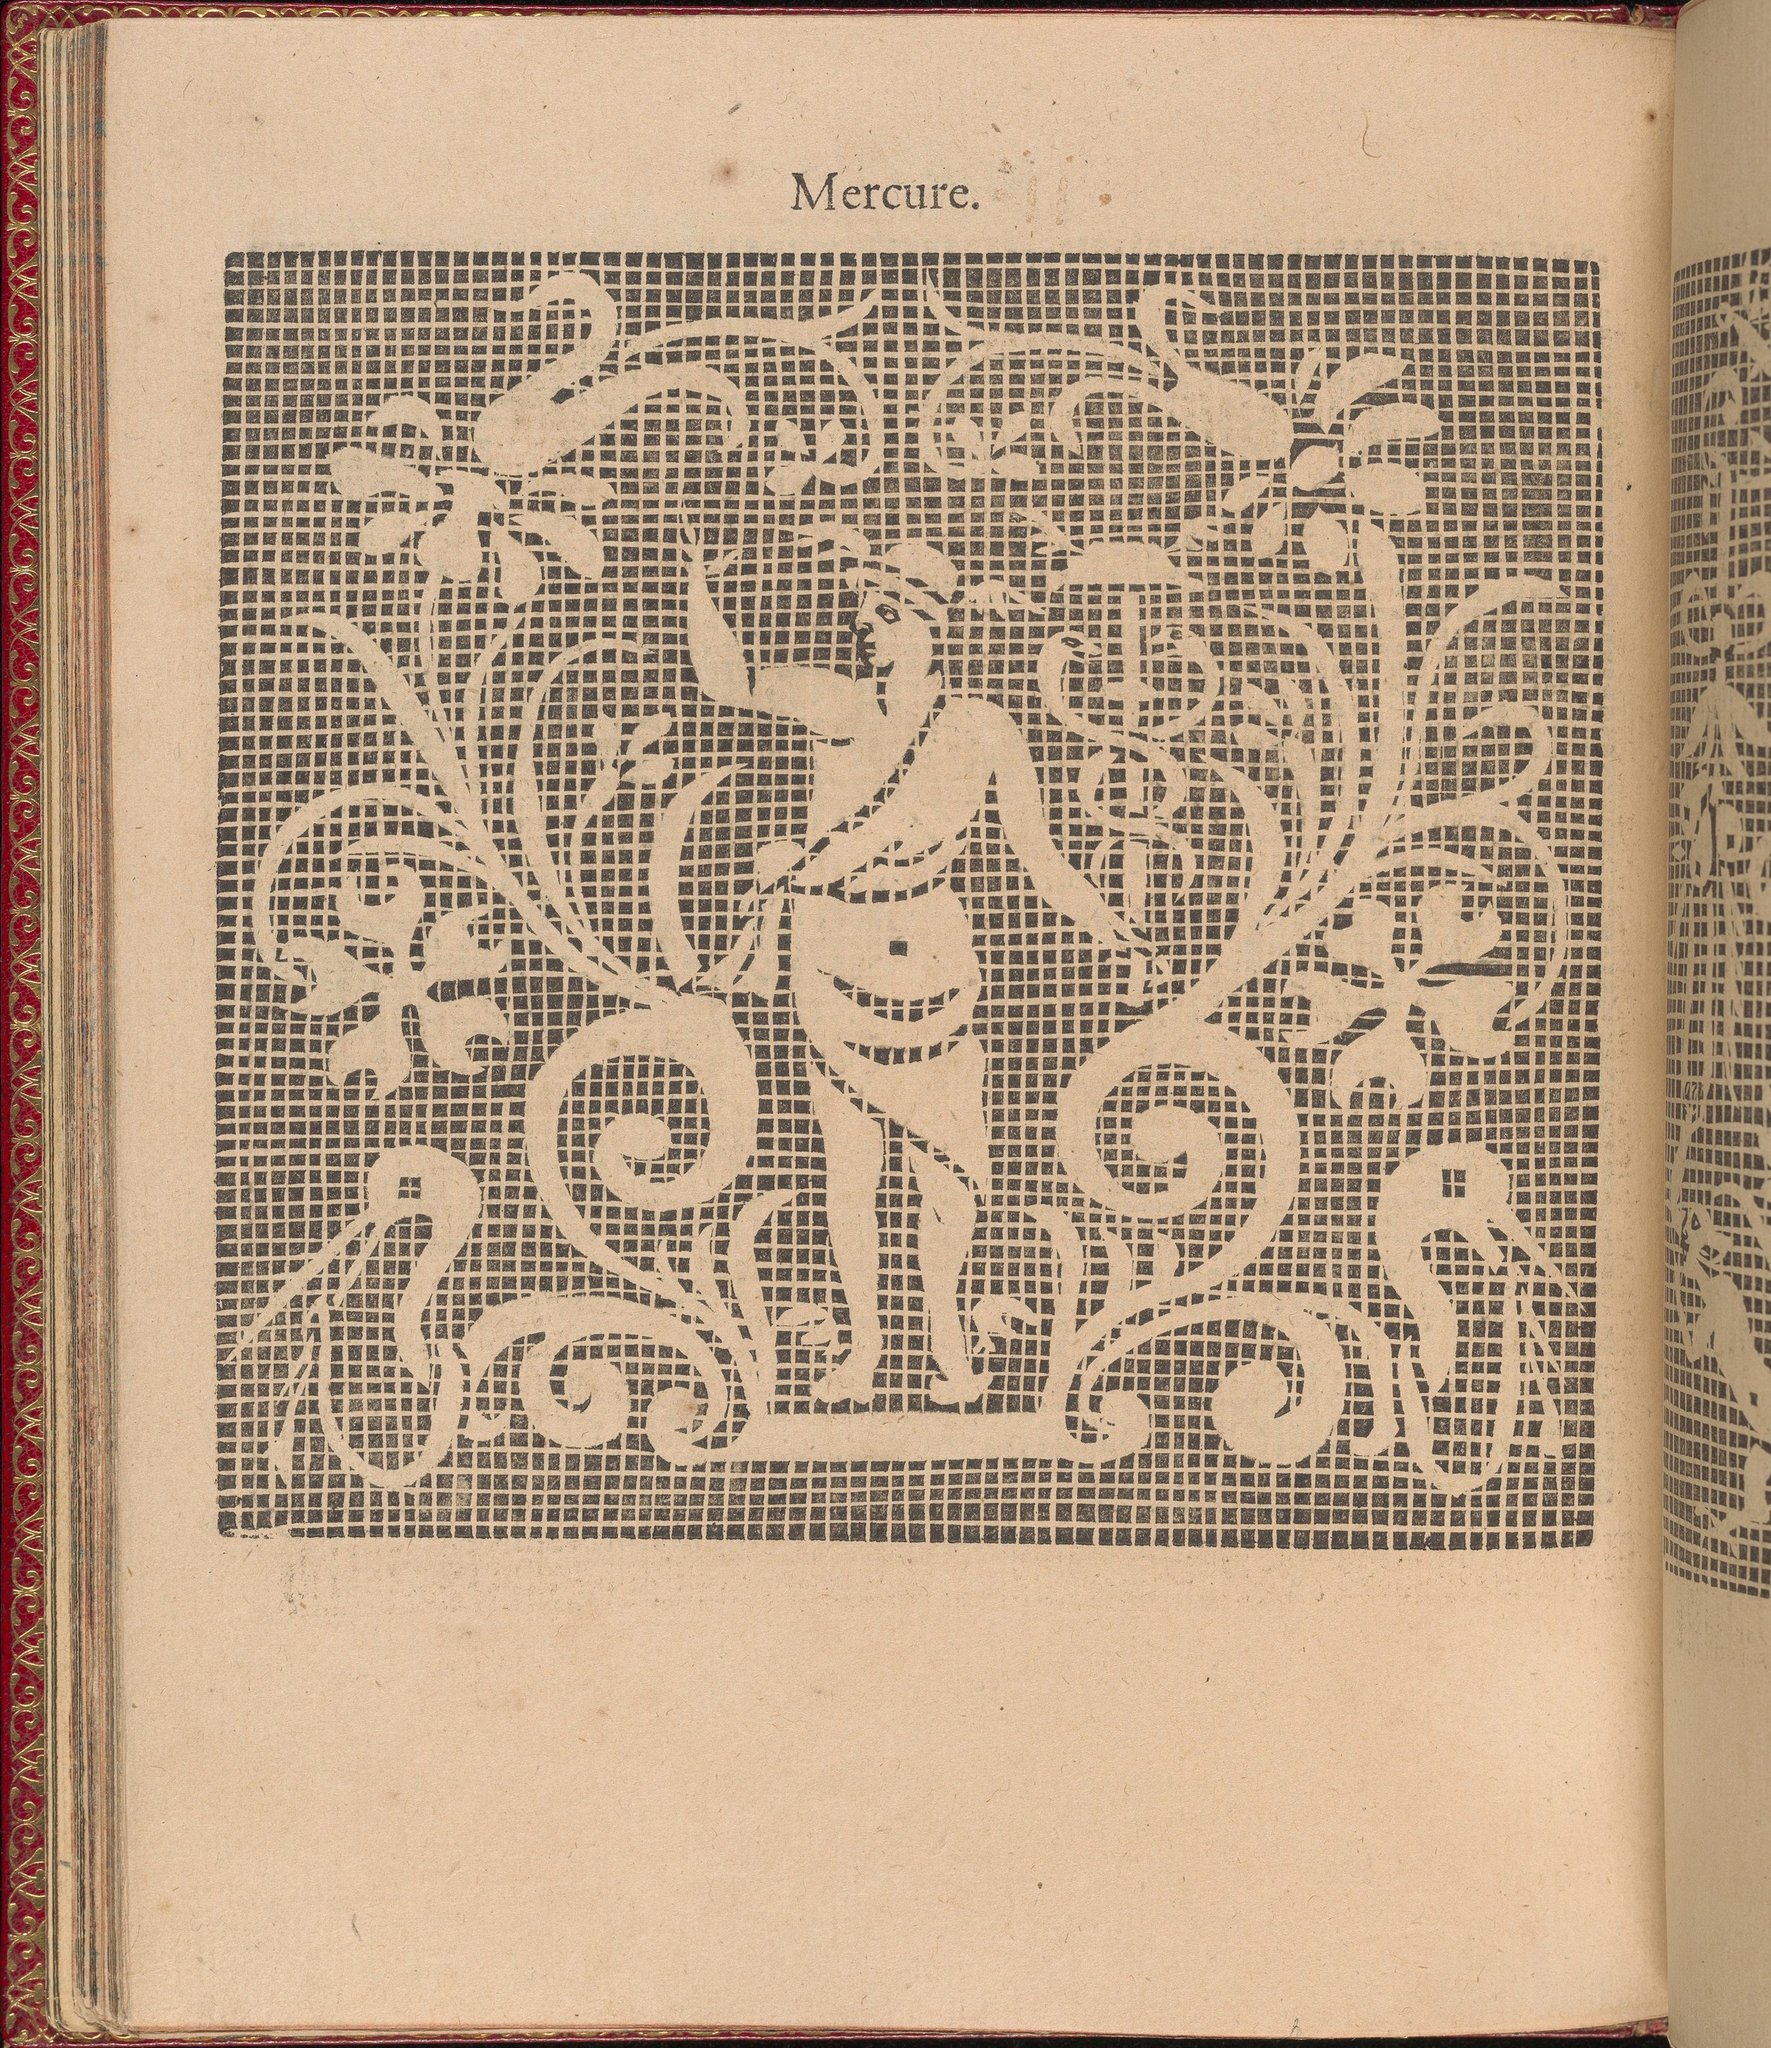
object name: book print ornament architecture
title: Les Singuliers et Nouveaux Portraicts... page 46 (verso)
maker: federico de vinciolo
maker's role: designer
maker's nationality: italian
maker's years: 1582-1599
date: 1588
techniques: woodcut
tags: mercury,snakes,flowers